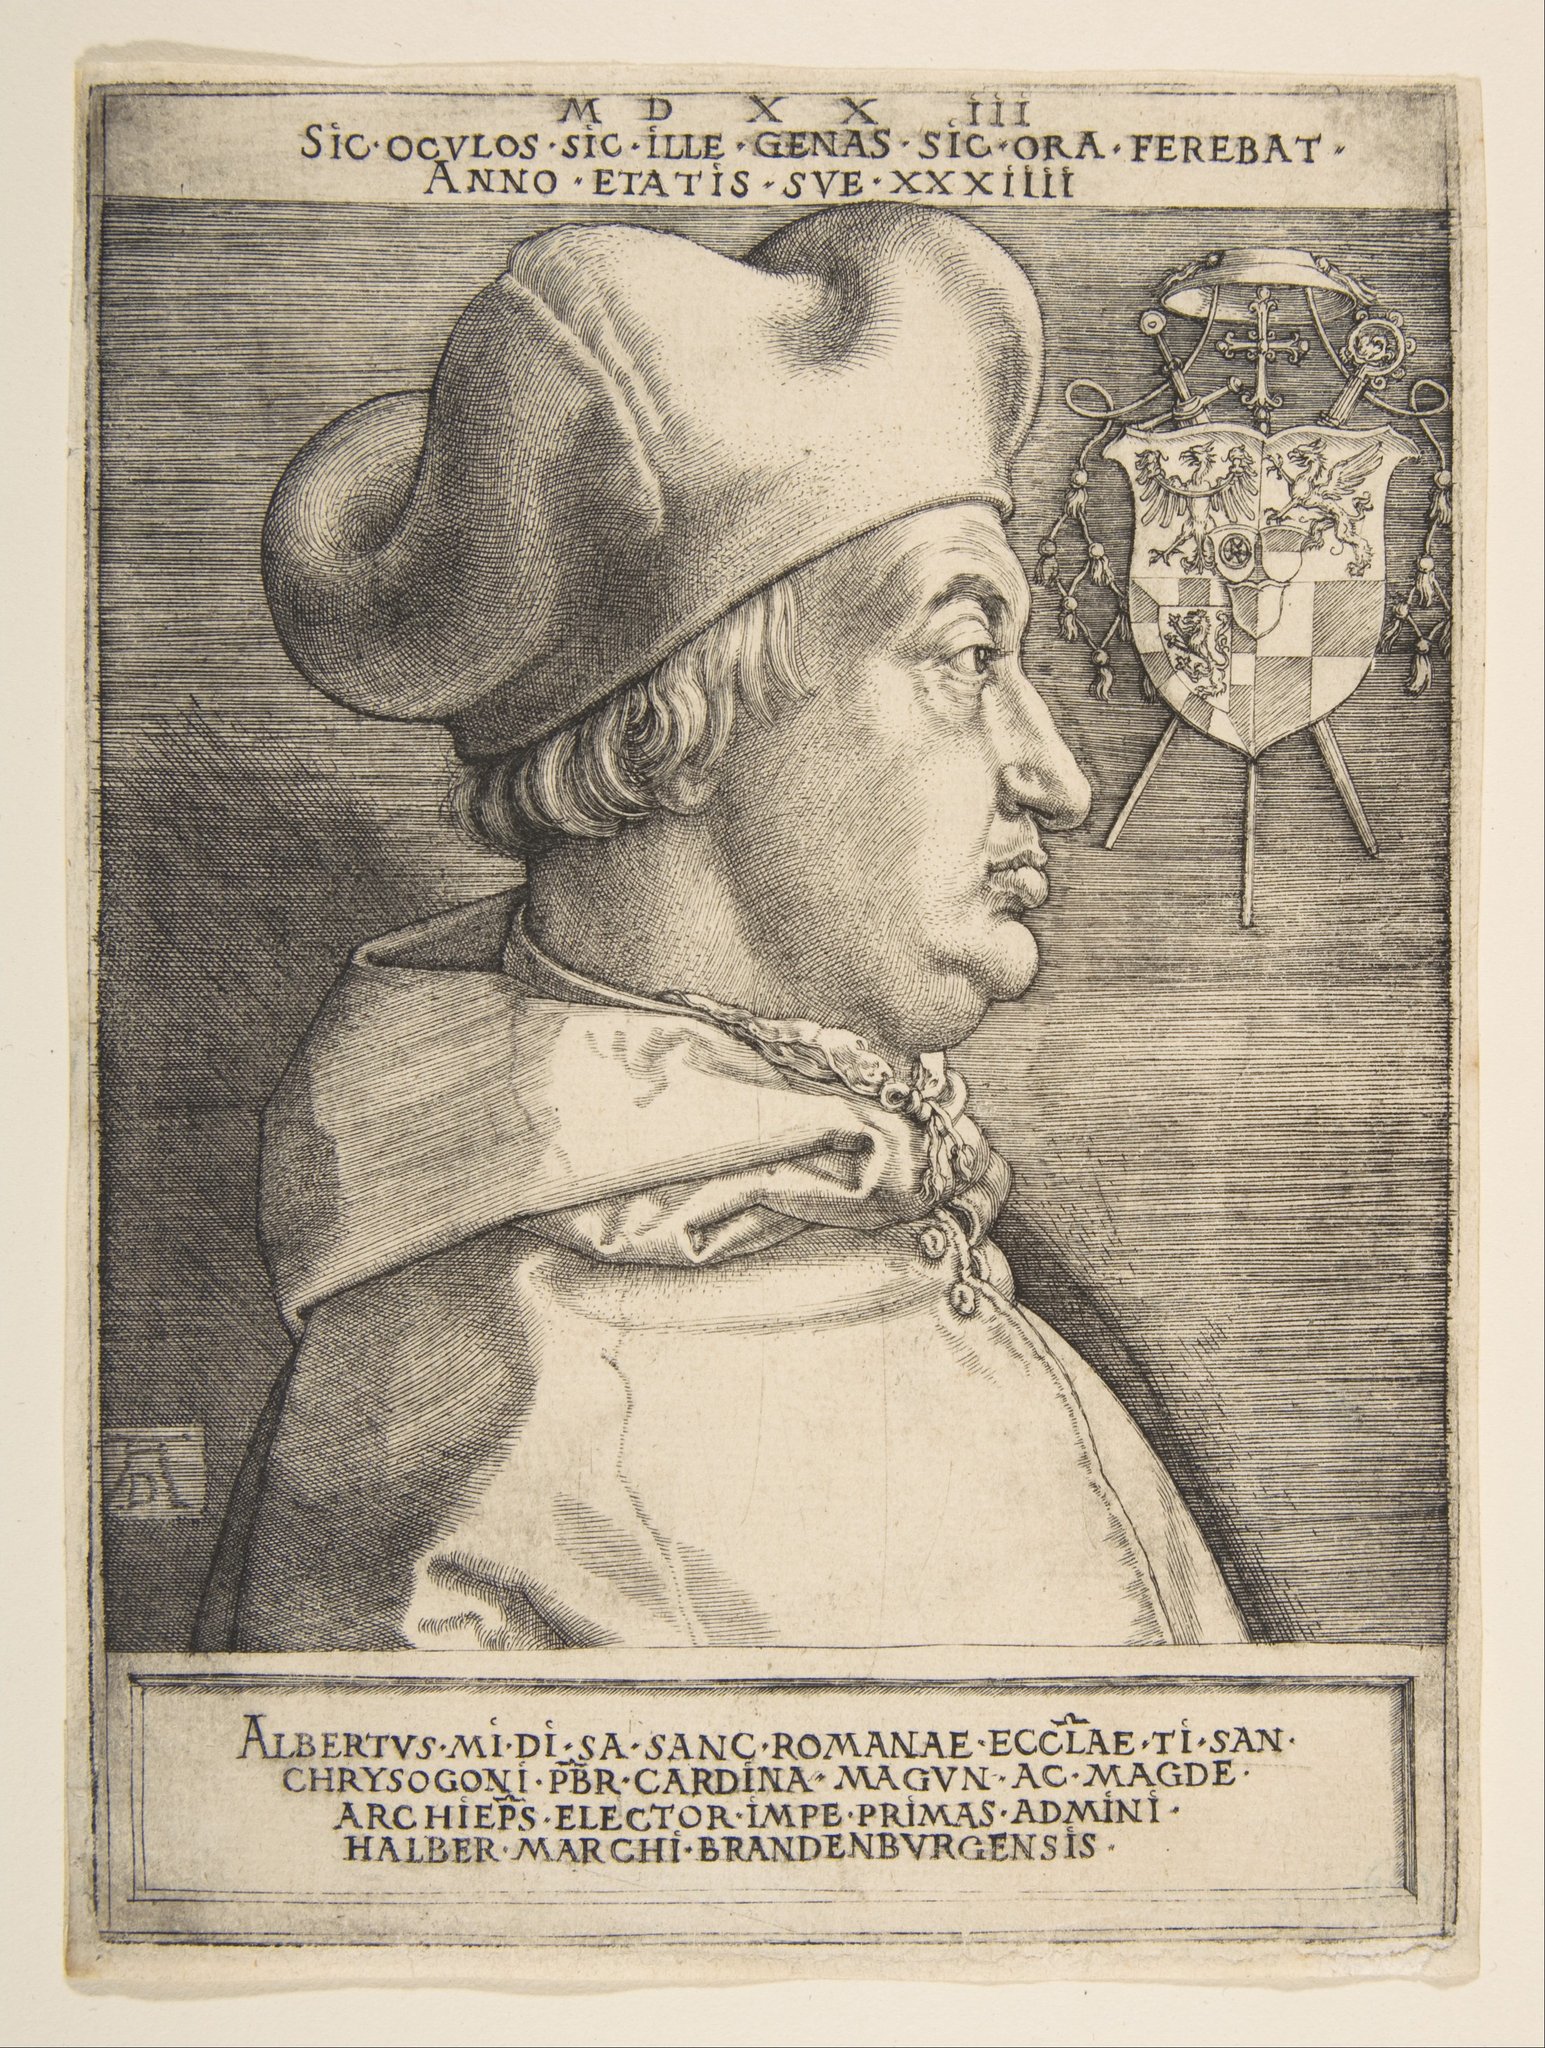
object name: print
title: Cardinal Albrecht of Brandenburg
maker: albrecht dürer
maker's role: artist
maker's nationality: german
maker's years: 1471-1528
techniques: engraving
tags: men,portraits,coat of arms